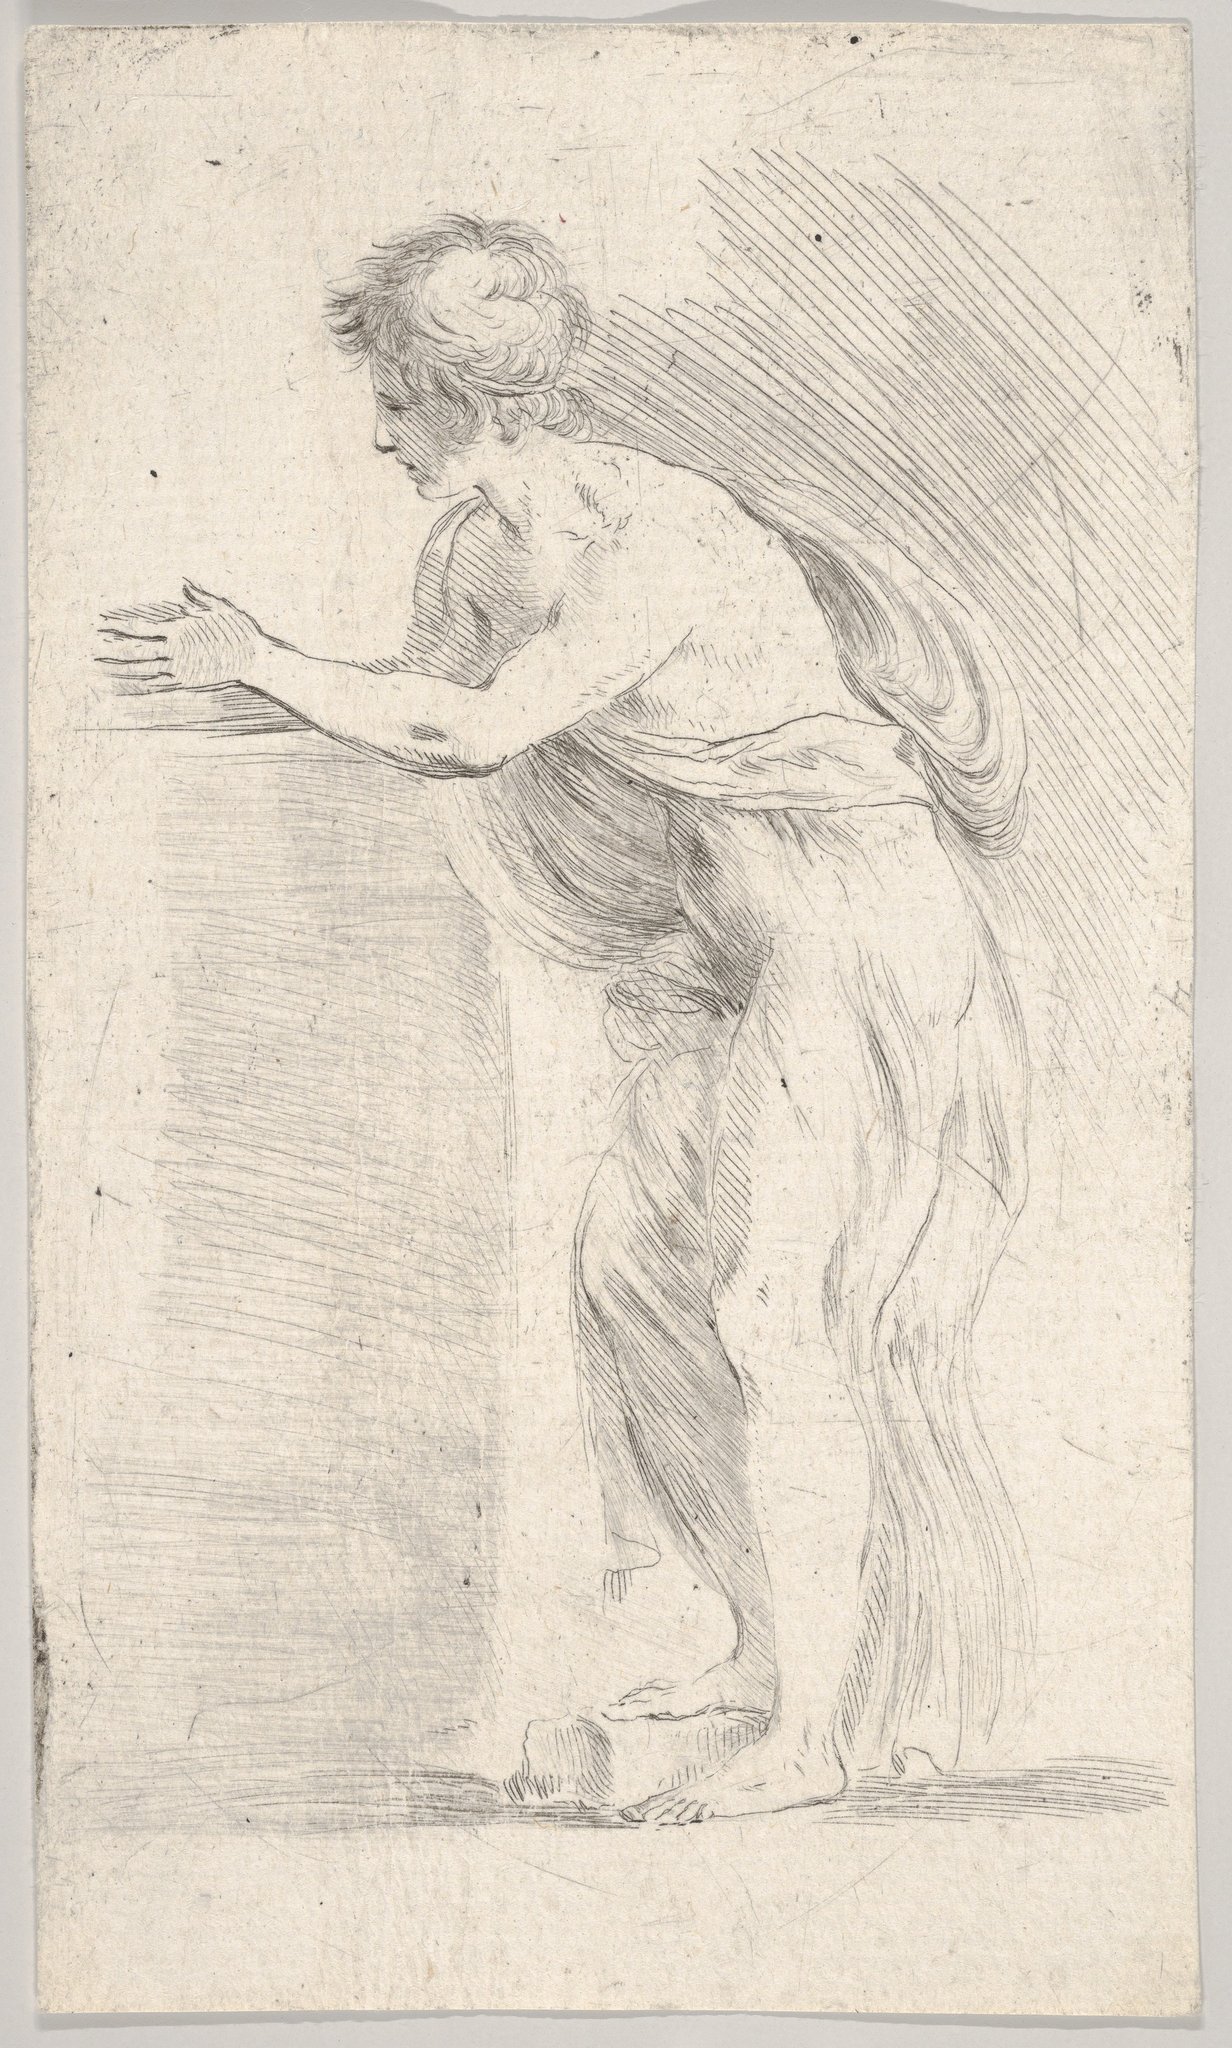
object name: print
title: Study of a young man pressing his hands together, standing in profile facing left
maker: stefano della bella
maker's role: artist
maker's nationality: italian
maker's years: 1610-1664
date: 1649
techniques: etching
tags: men,profiles